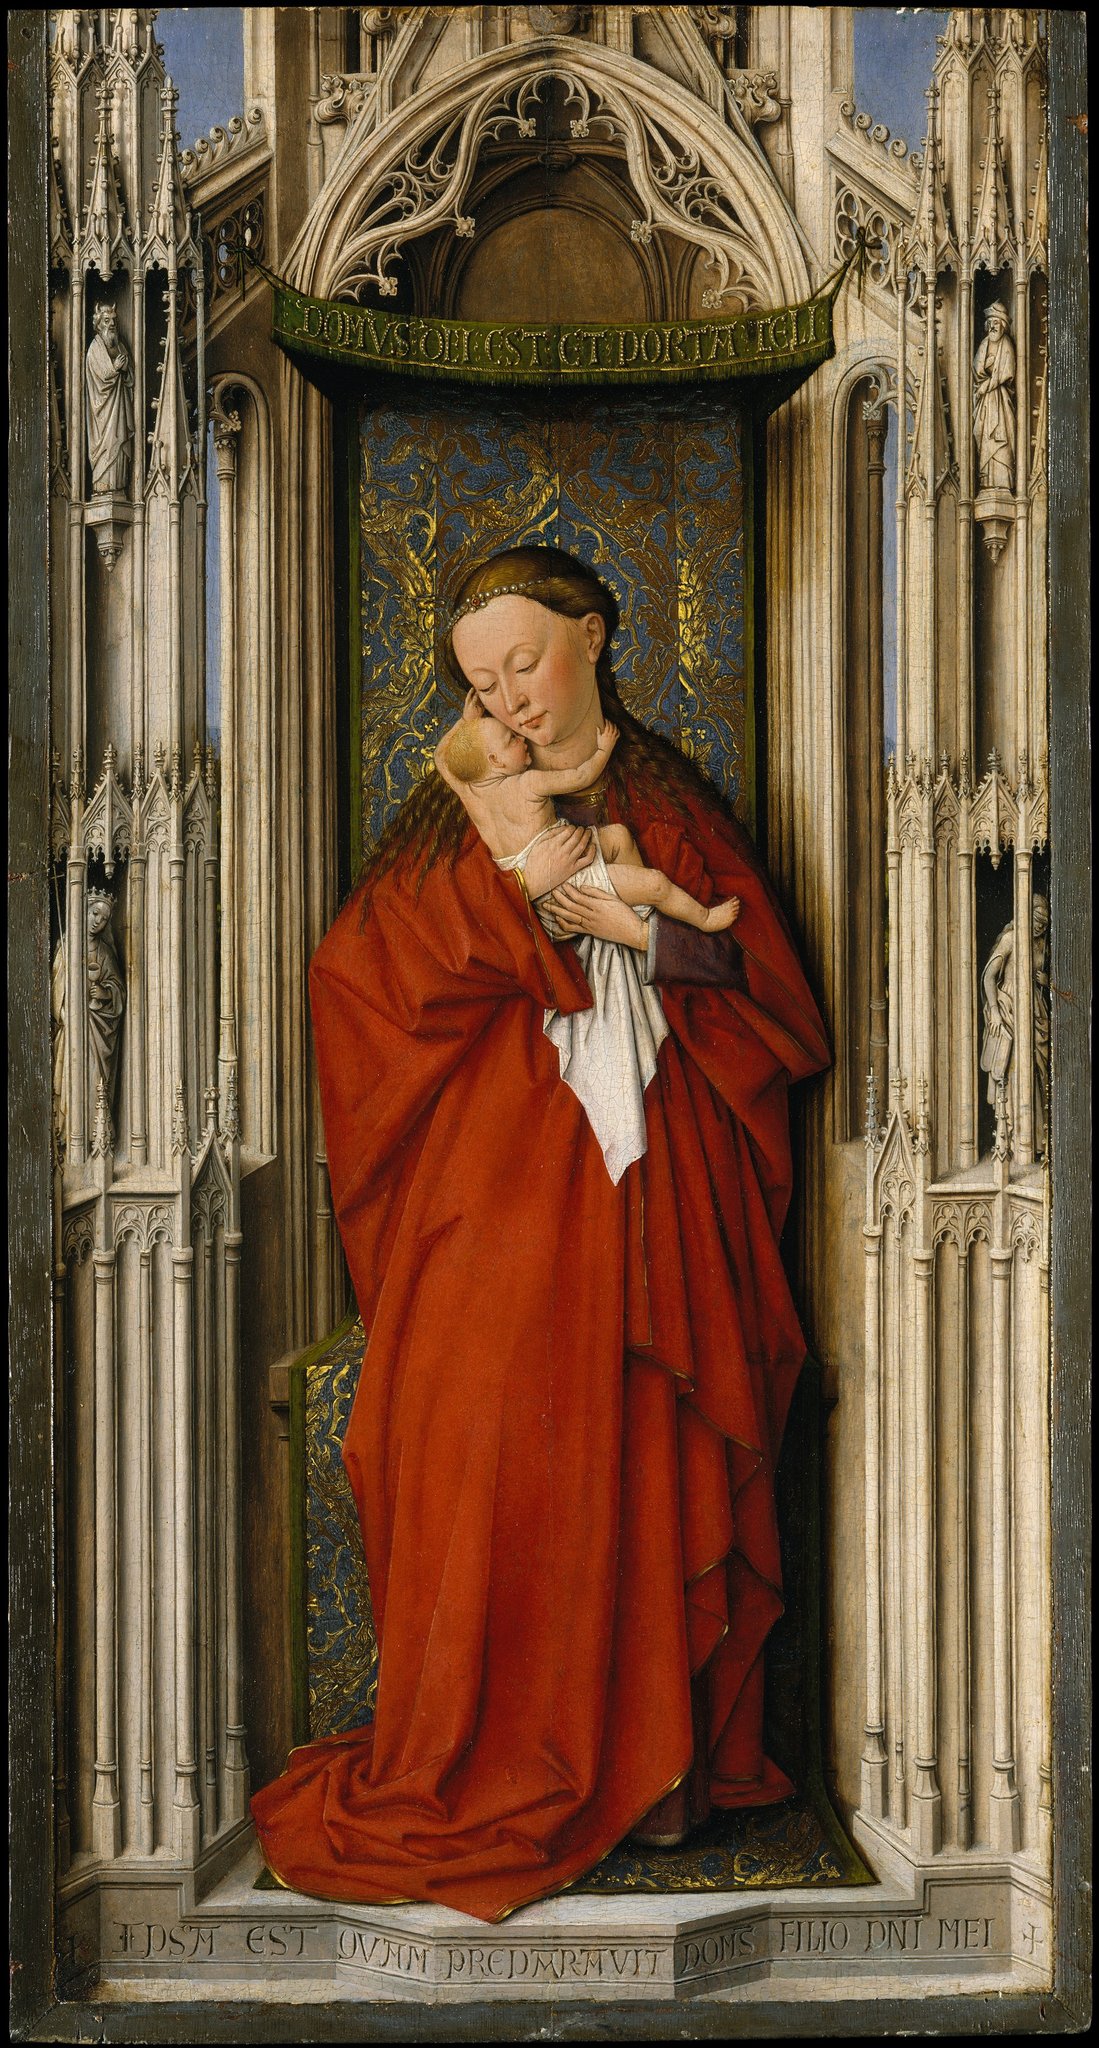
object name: painting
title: Virgin and Child in a Niche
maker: jan van eyck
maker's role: artist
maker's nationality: netherlandish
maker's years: 1390-1441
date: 1440-1450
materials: oil, wood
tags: madonna and child,virgin mary